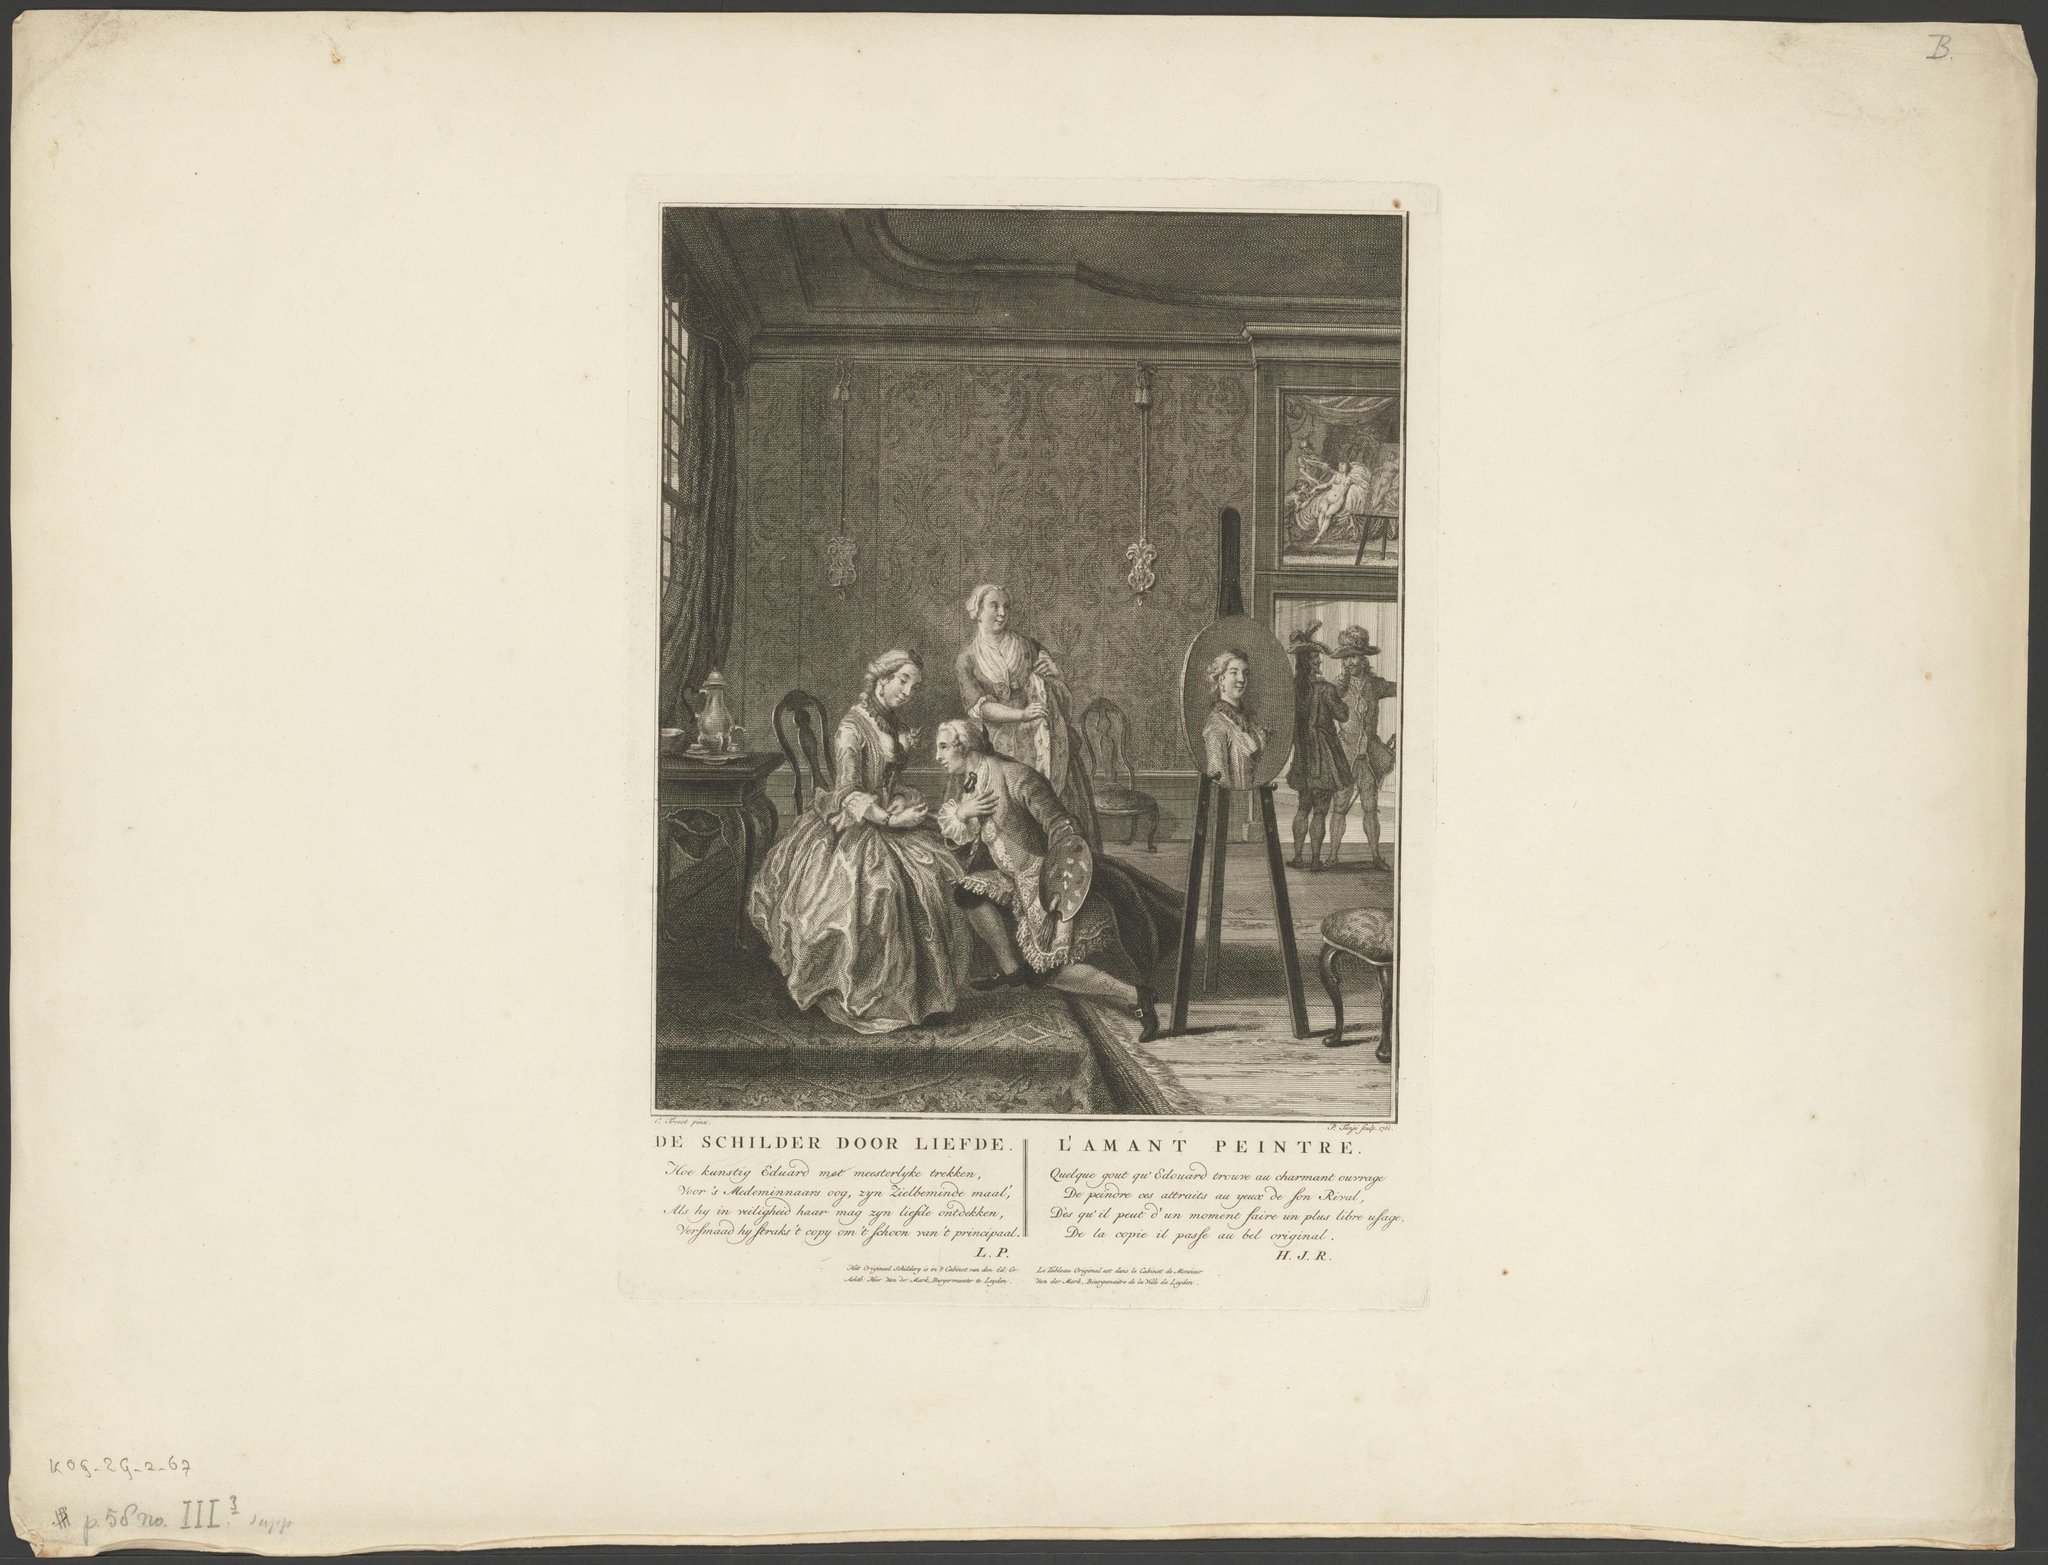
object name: print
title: De schilder door liefde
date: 1761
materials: paper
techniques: engraving, etching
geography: amsterdam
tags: kneeling figure, apelles paints campaspe and falls in love with her; alexander yields her to him, painter working from clothed model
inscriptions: collector's mark: Lugt 2488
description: De schilder Eduard verklaart Leonoor, wier portret hij vervaardigd heeft, zijn liefde. Bij de deur staat Leonoors jaloerse man Don Pedro, die door de schildersknecht bezig wordt gehouden. Boven de deur hangt een schilderij met een voorstelling van Alexander, die de schilder Apelles zijn minnares Campaspe ten geschenke geeft. Onderaan in de marge vierregelige verzen in het Nederlands en het Frans. Scène uit het tweede bedrijf van het toneelstuk De schilder door liefde, van Molière.